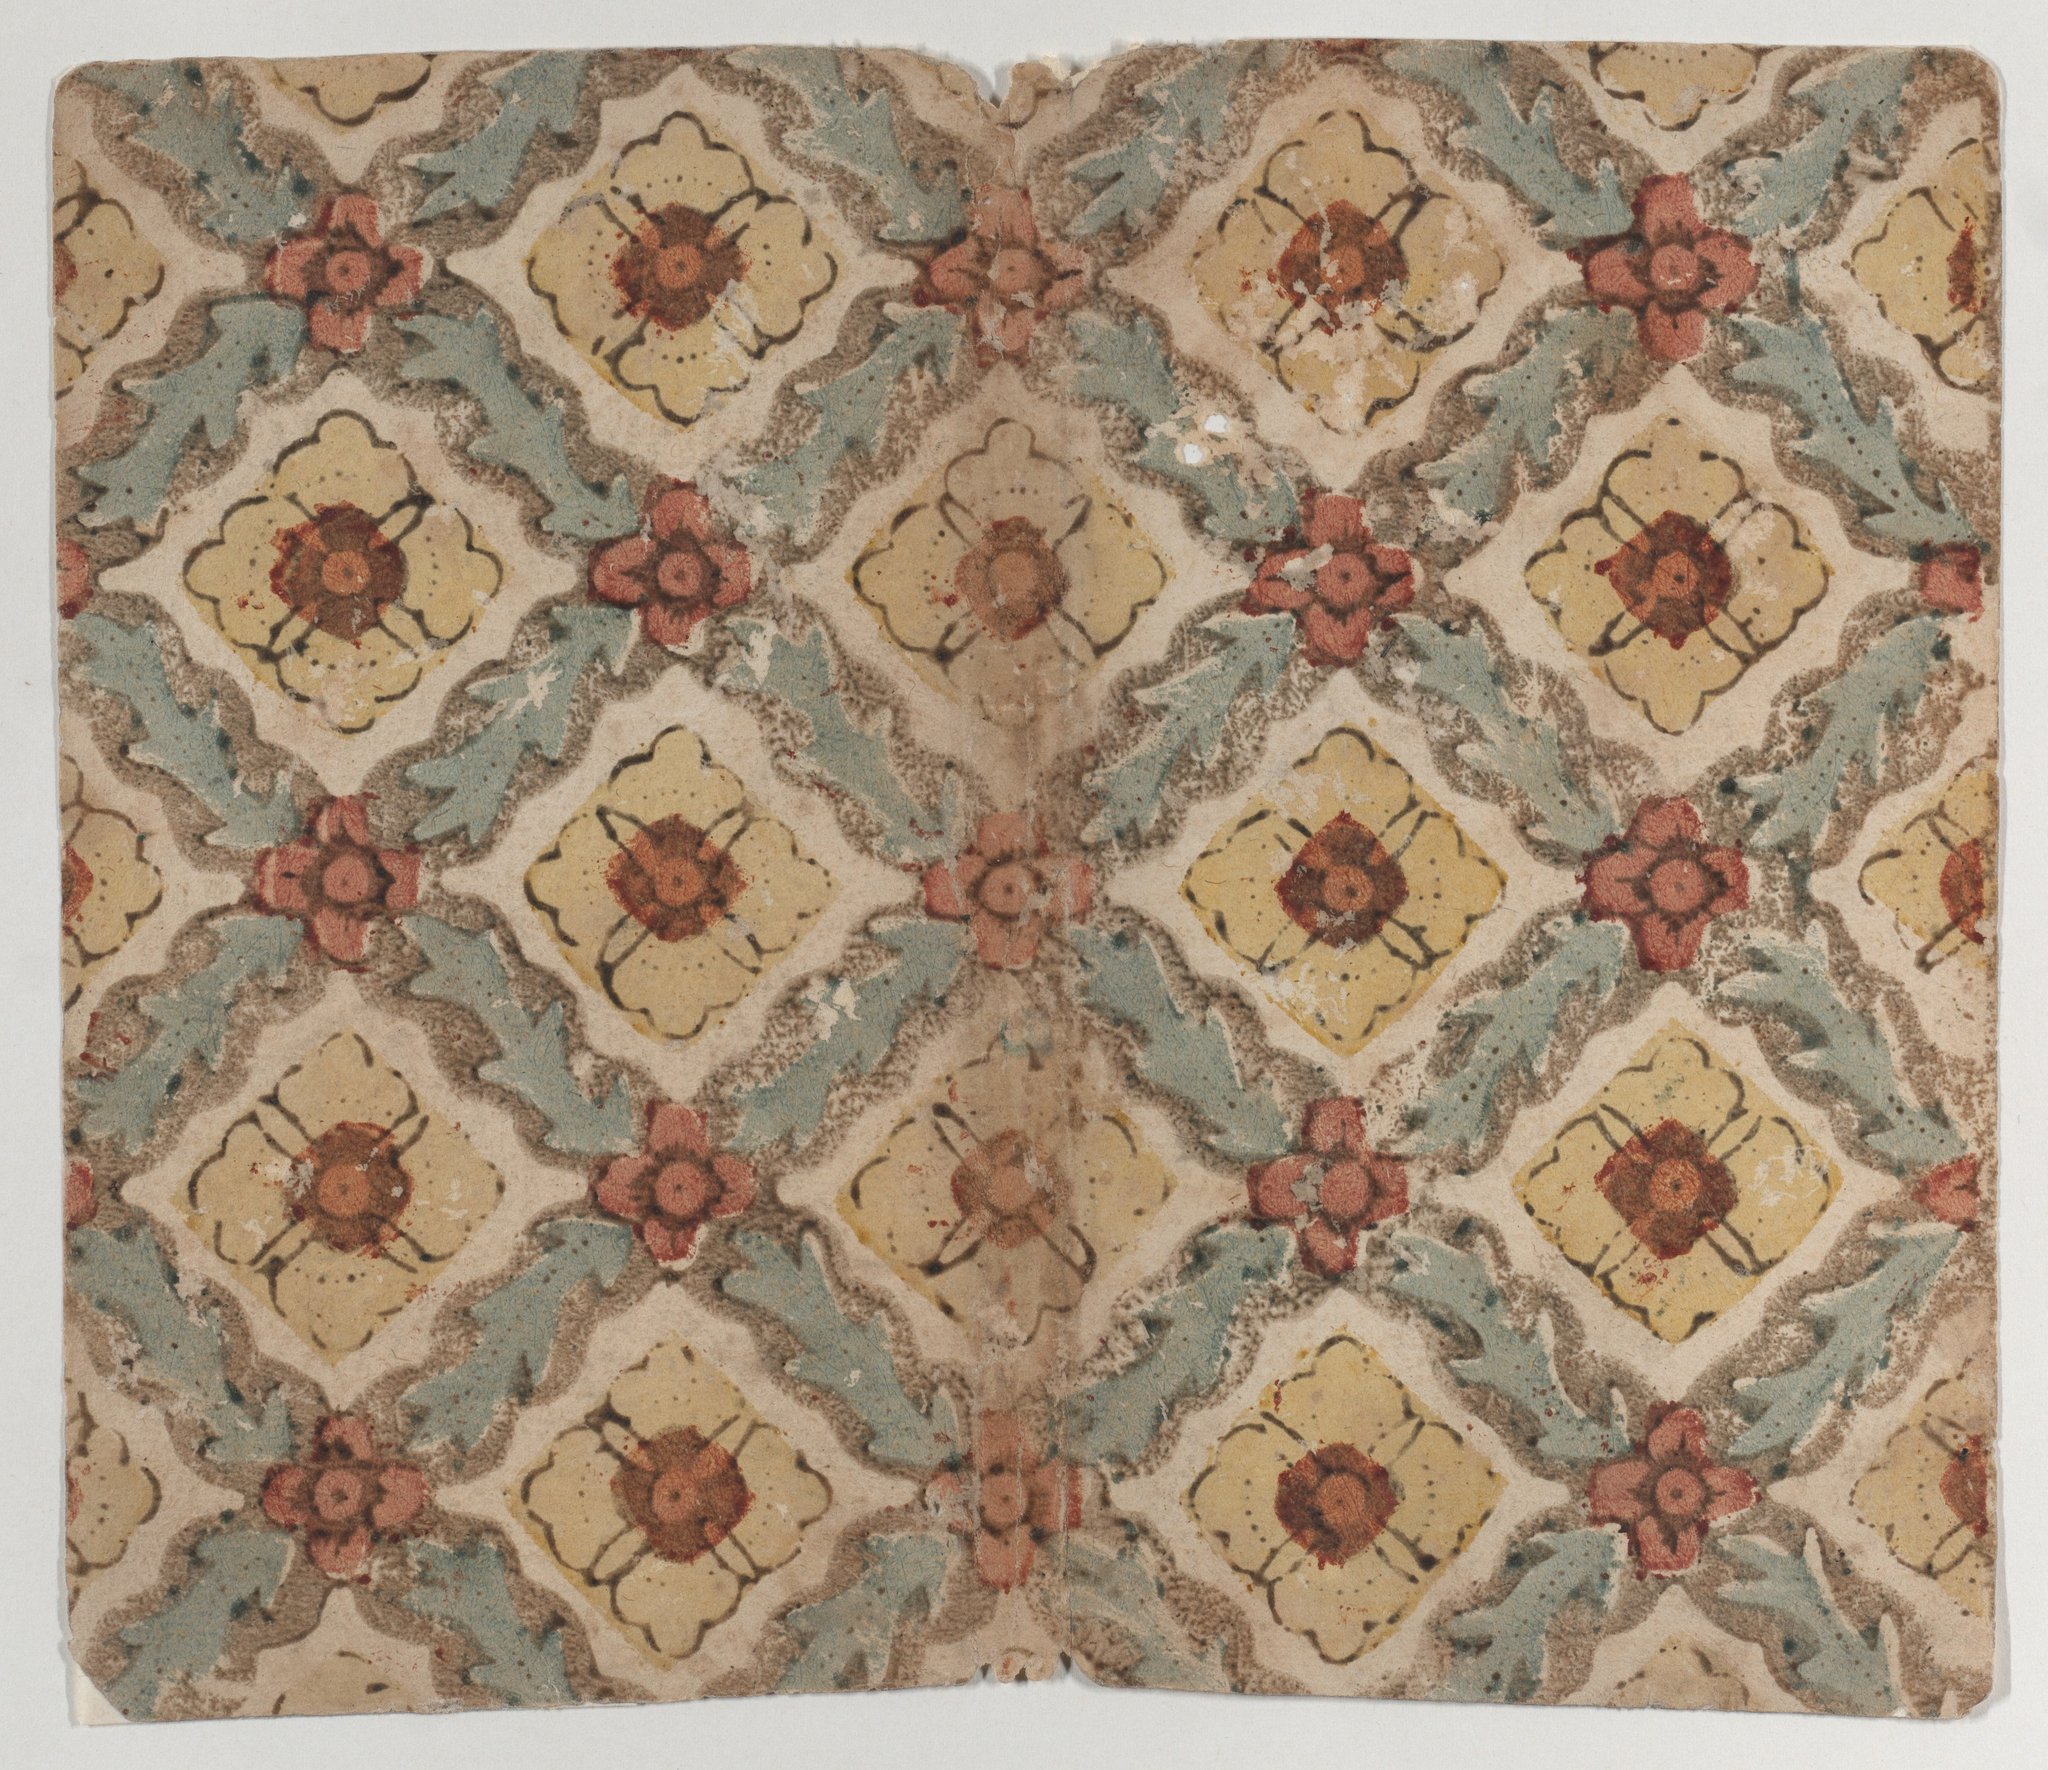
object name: print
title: Sheet with crisscross and zigzag pattern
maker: Anonymous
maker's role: artist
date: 1701-1800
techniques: relief print